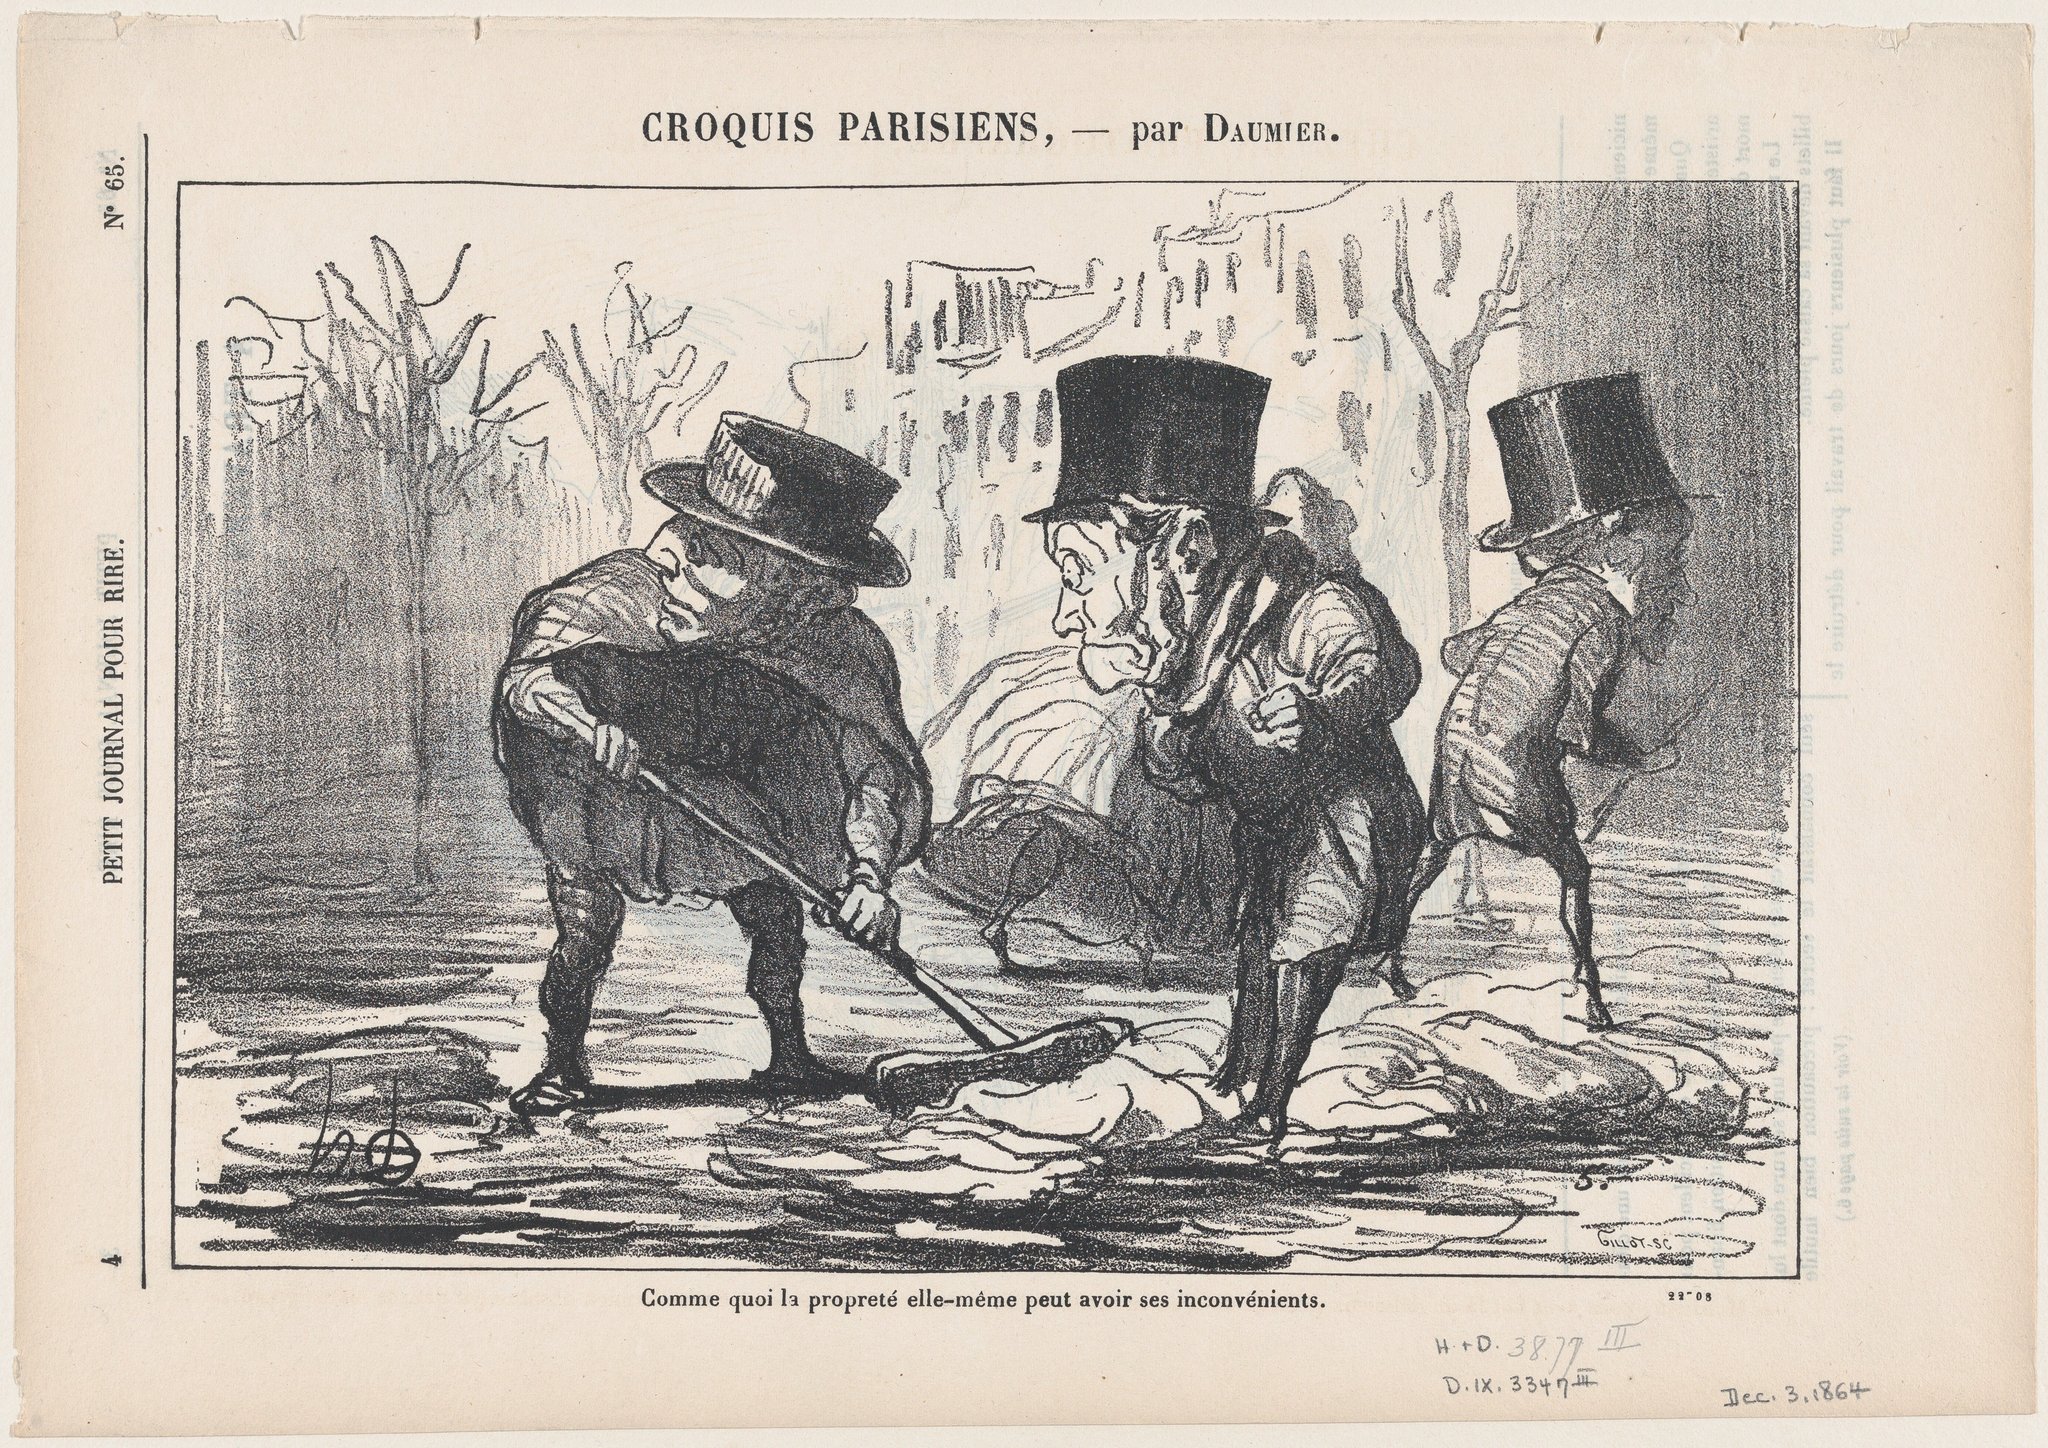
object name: print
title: Which shows that even cleanliness can be hazardous, from "Parisian Sketches"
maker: honoré daumier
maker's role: artist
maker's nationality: french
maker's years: 1808-1879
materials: paper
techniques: lithograph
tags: satire,men